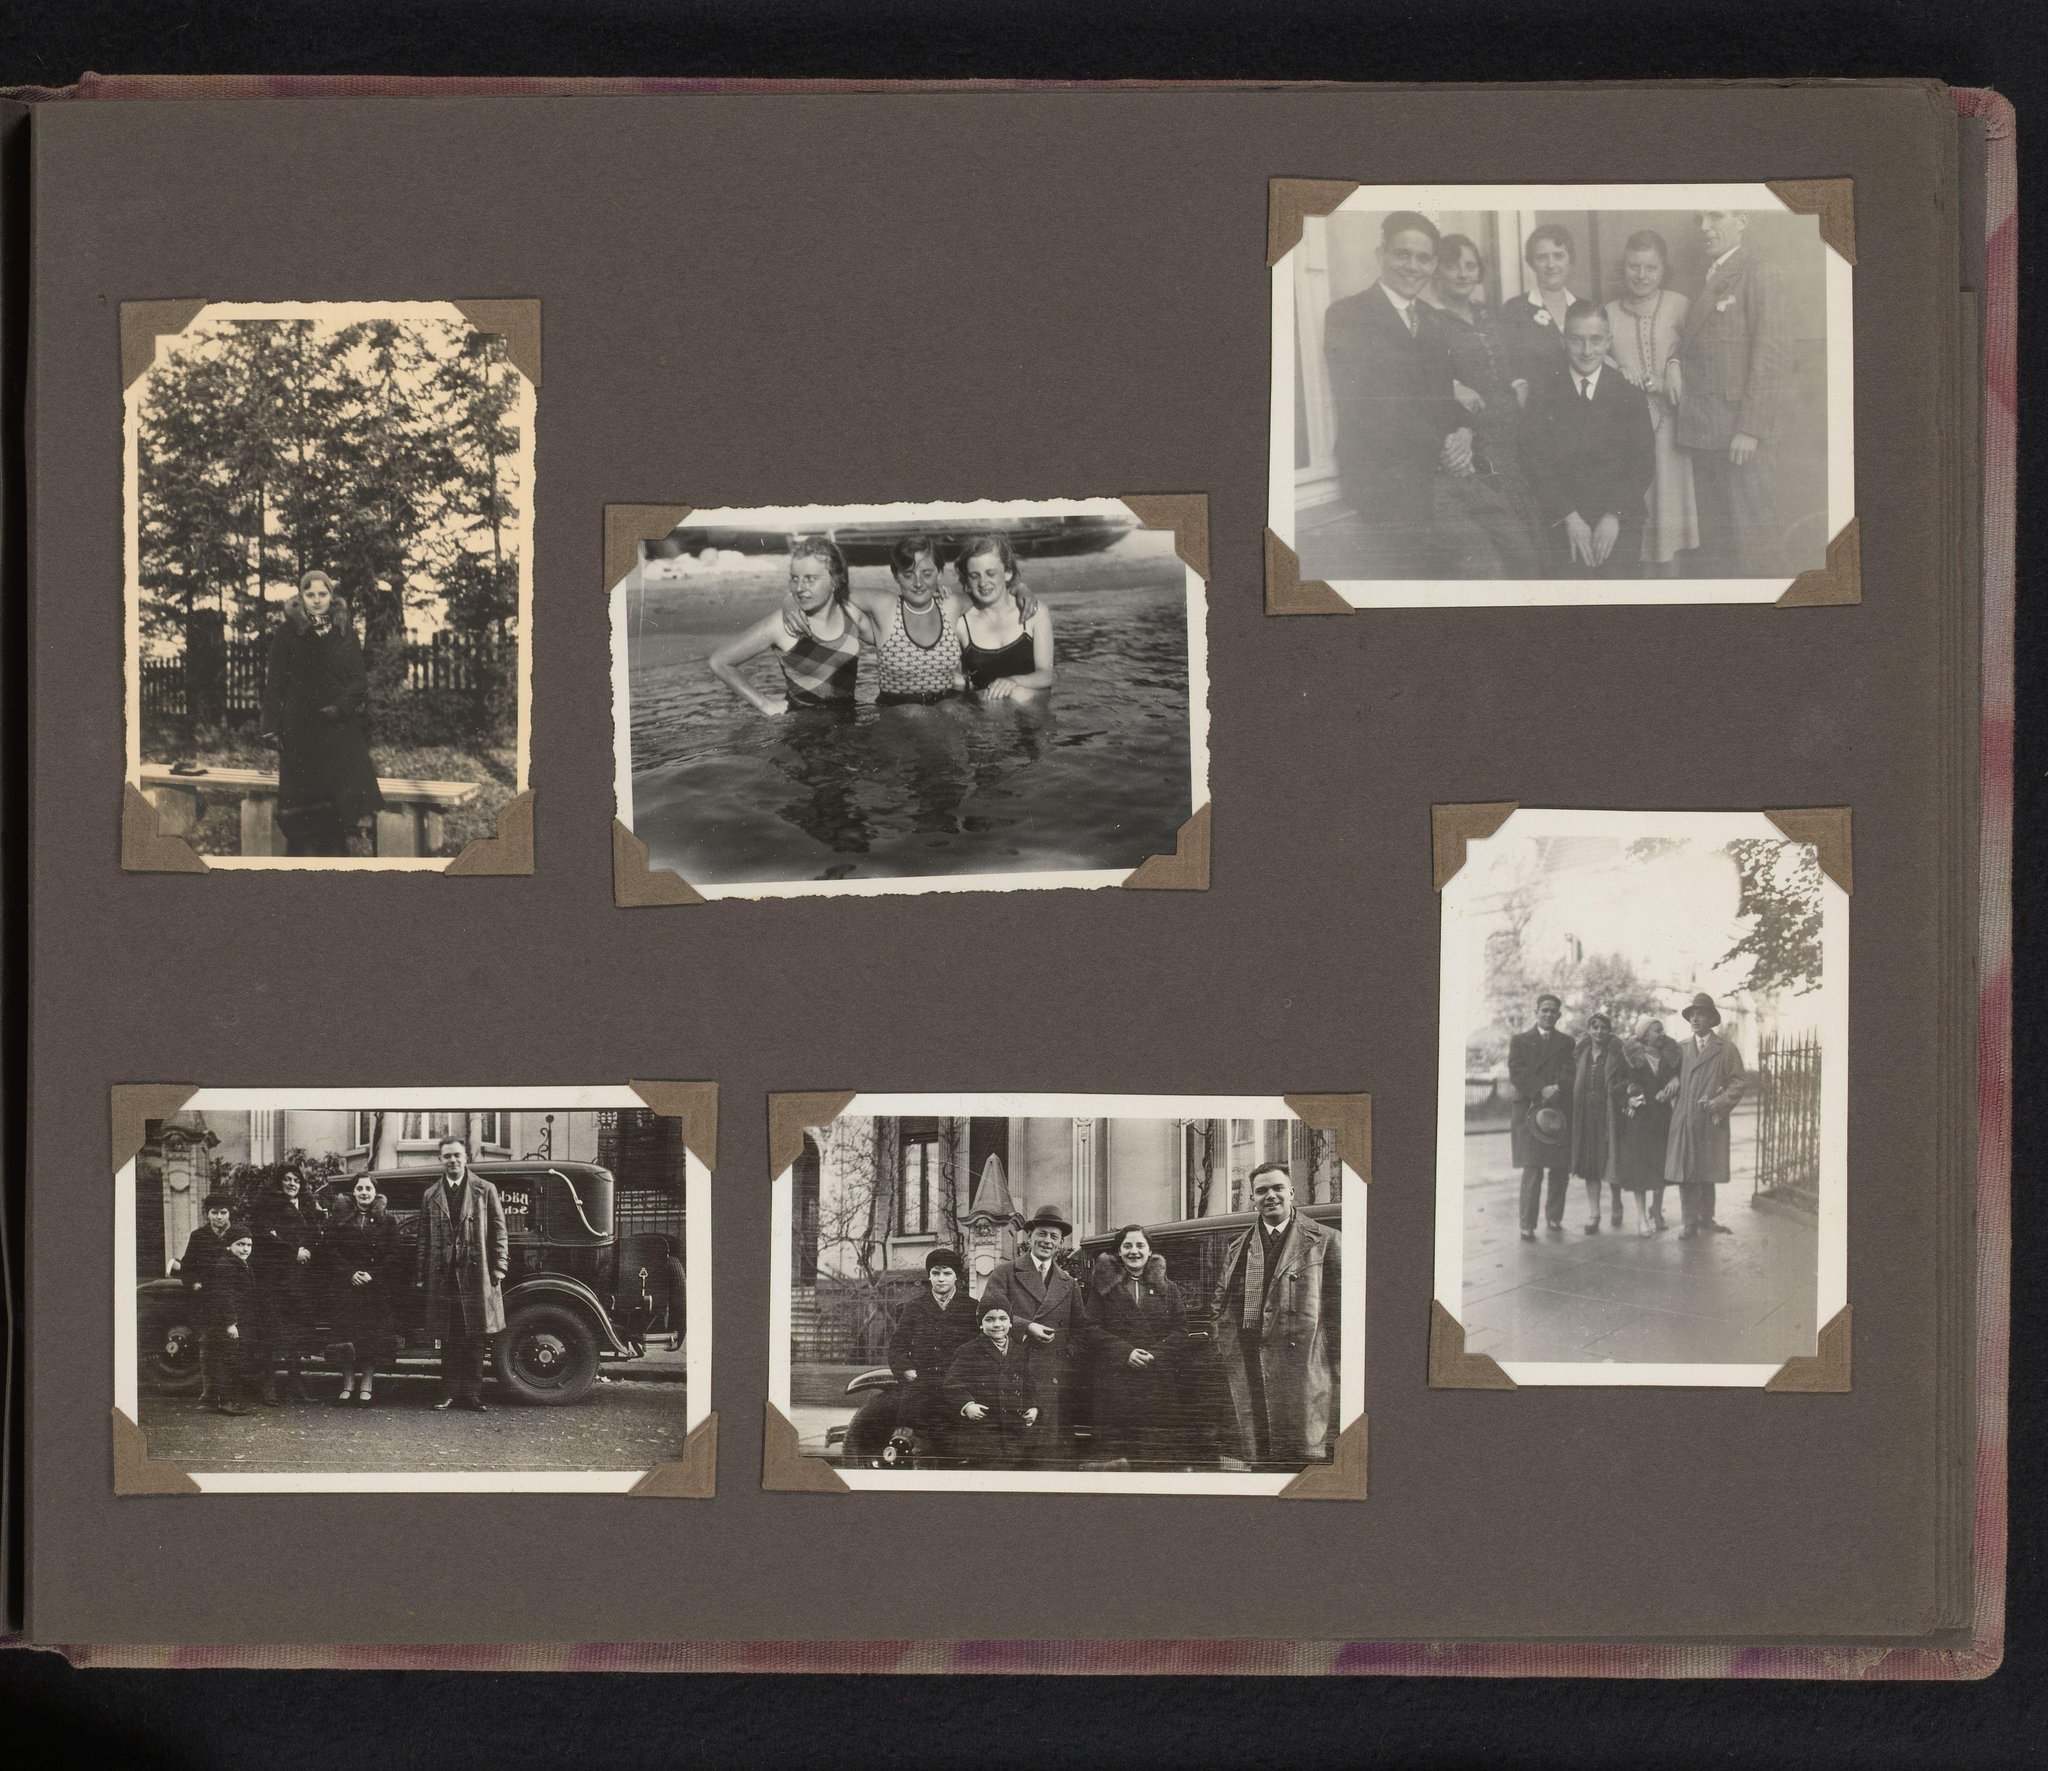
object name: photograph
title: Zes portretten van Herman Besselaar, Berti Hoppe en kennissen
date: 1930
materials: cardboard, photographic support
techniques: gelatin silver print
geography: netherlands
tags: herman besselaar, berti hoppe, historical persons - bb - woman, anonymous historical persons portrayed in a group, in a group-portrait, netherlands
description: Deze foto's maken deel uit van een album.